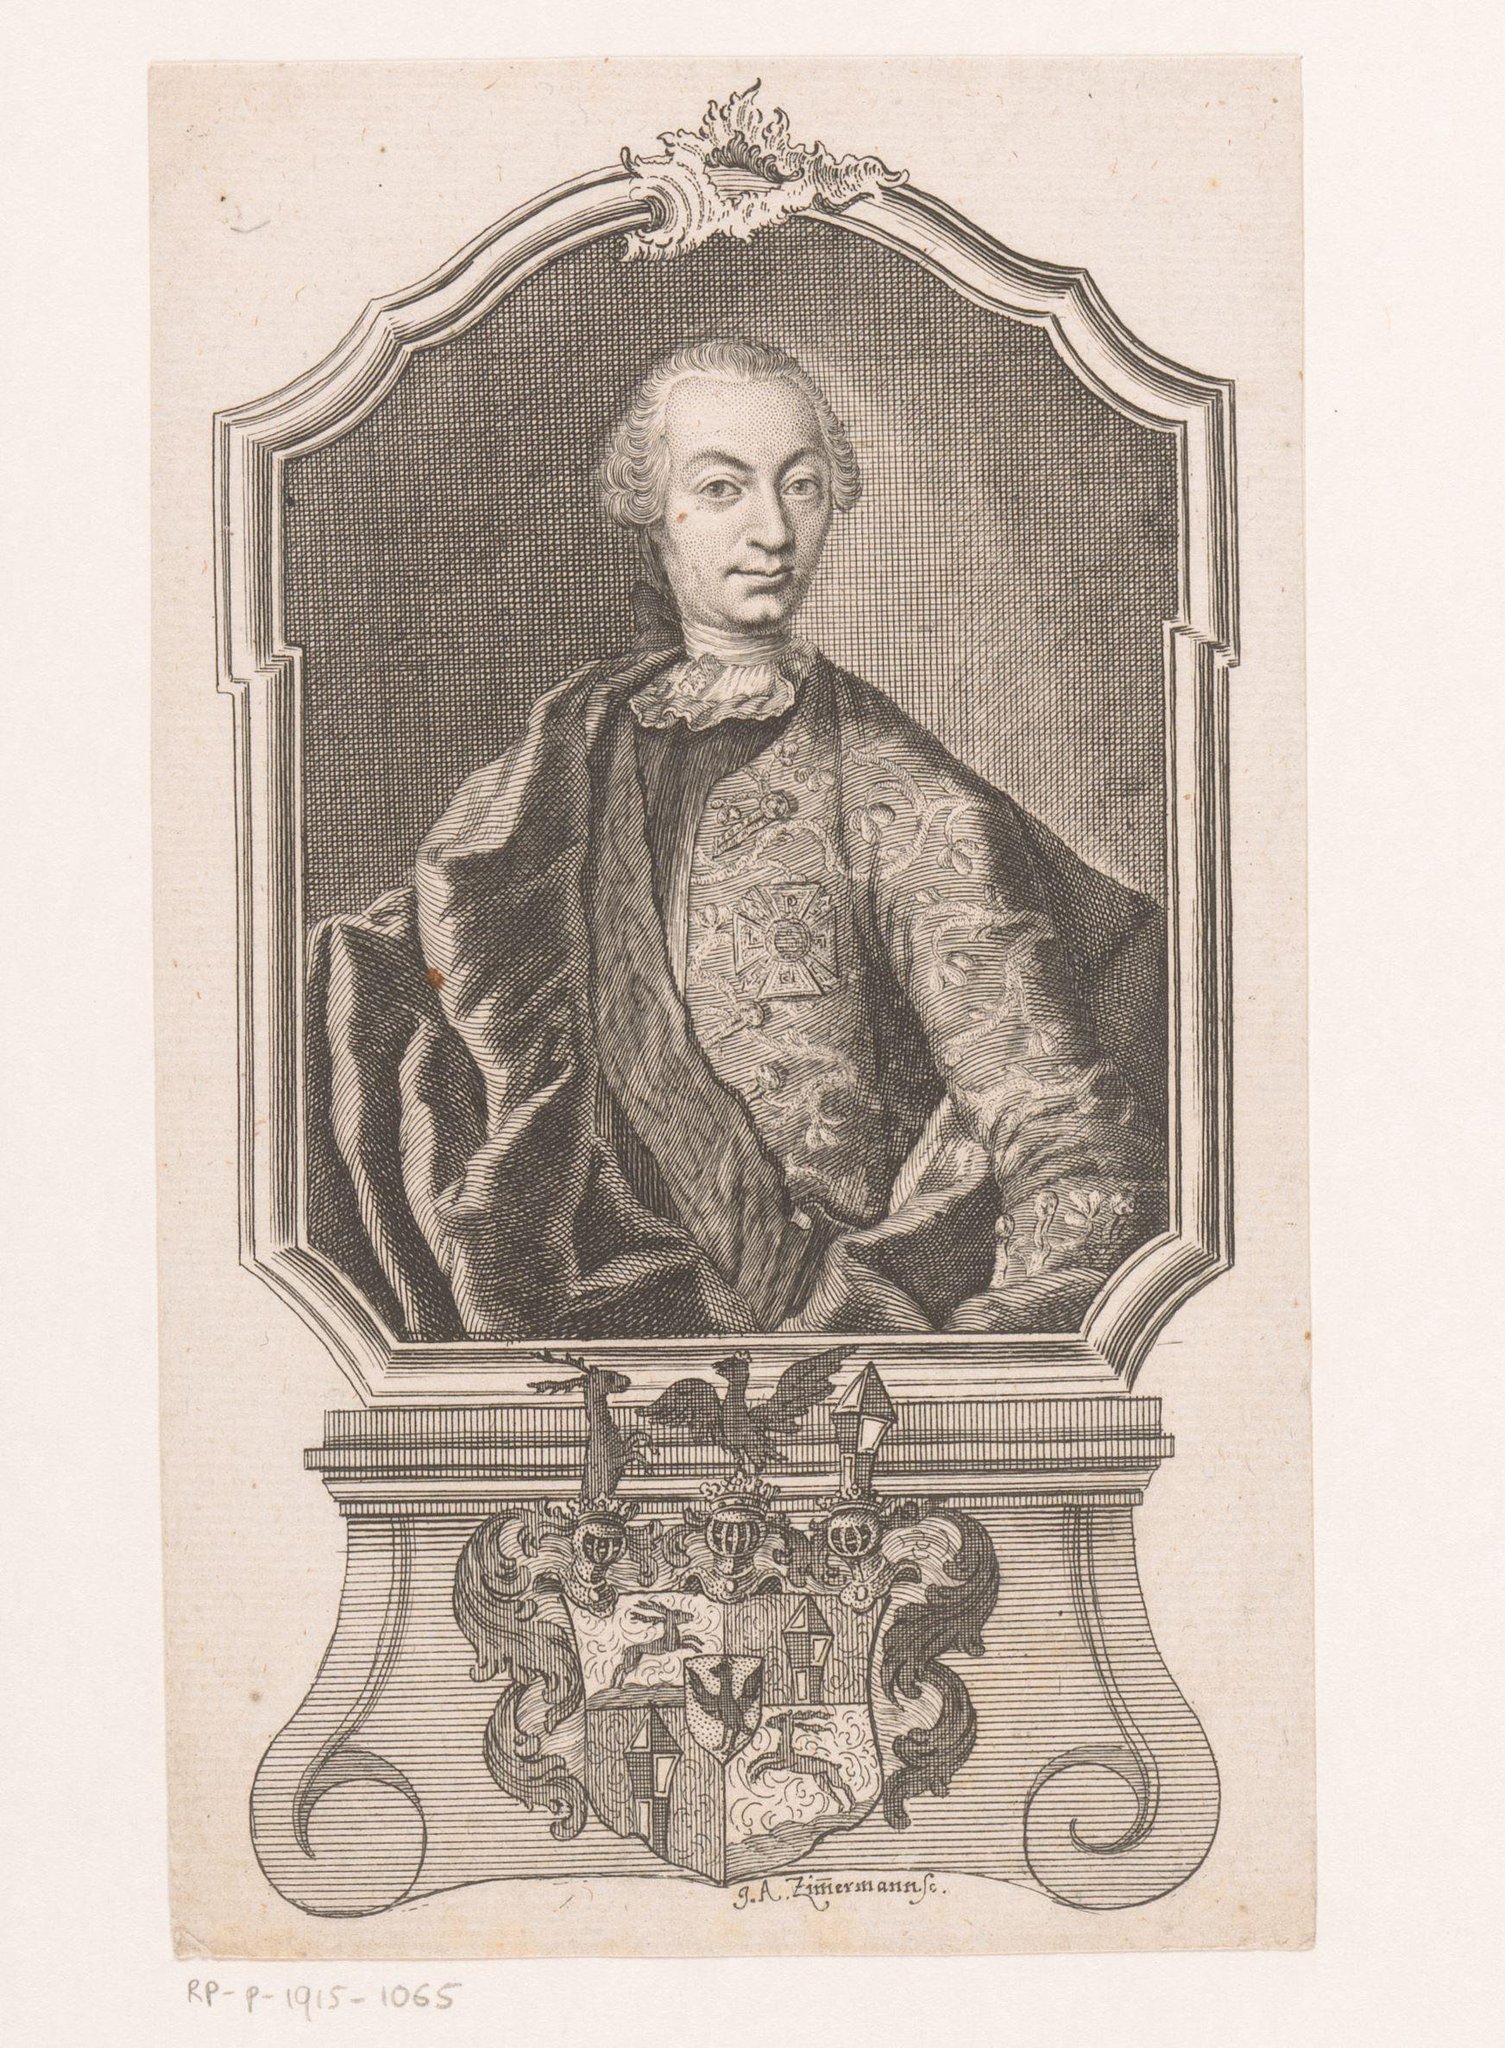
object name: print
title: Portret van een onbekende man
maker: joseph anton zimmermann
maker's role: draughtsman, print maker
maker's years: 1705-1797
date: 1715-1797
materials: paper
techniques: engraving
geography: germany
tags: historical persons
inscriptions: collector's mark: Lugt 2228